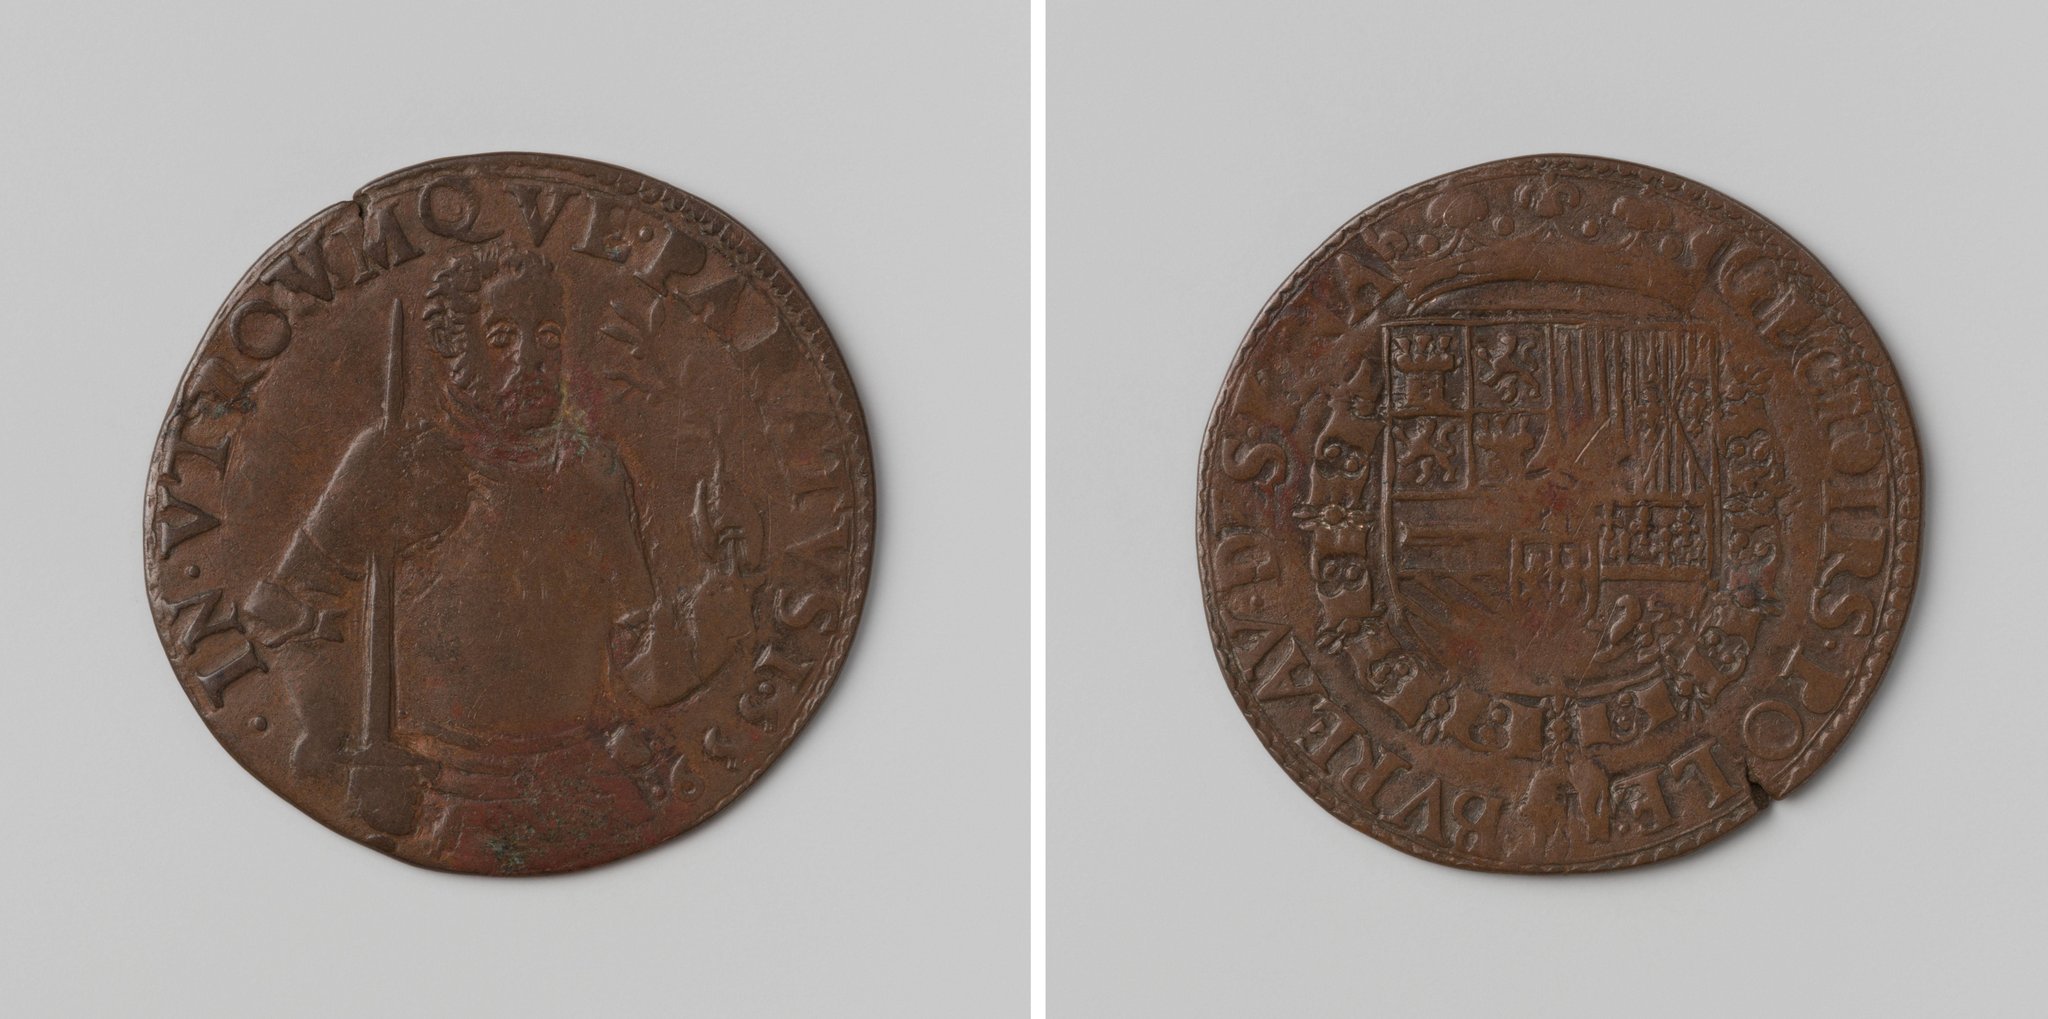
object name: jeton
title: Begin van vredesonderhandelingen tussen Engeland, Spanje en Frankrijk te Kamerijk, rekenpenning van de raad van Financien ter ere van Filips II, koning van Spanje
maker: Anonymous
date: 1558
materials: copper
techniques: striking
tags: philip ii of spain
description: Koperen penning. Voorzijde: portret man met olijftak in linker- en zwaard in rechterhand binnen omschrift. Keerzijde: gekroond wapenschild omhangen met orde van Gulden Vlies binnen omschrift